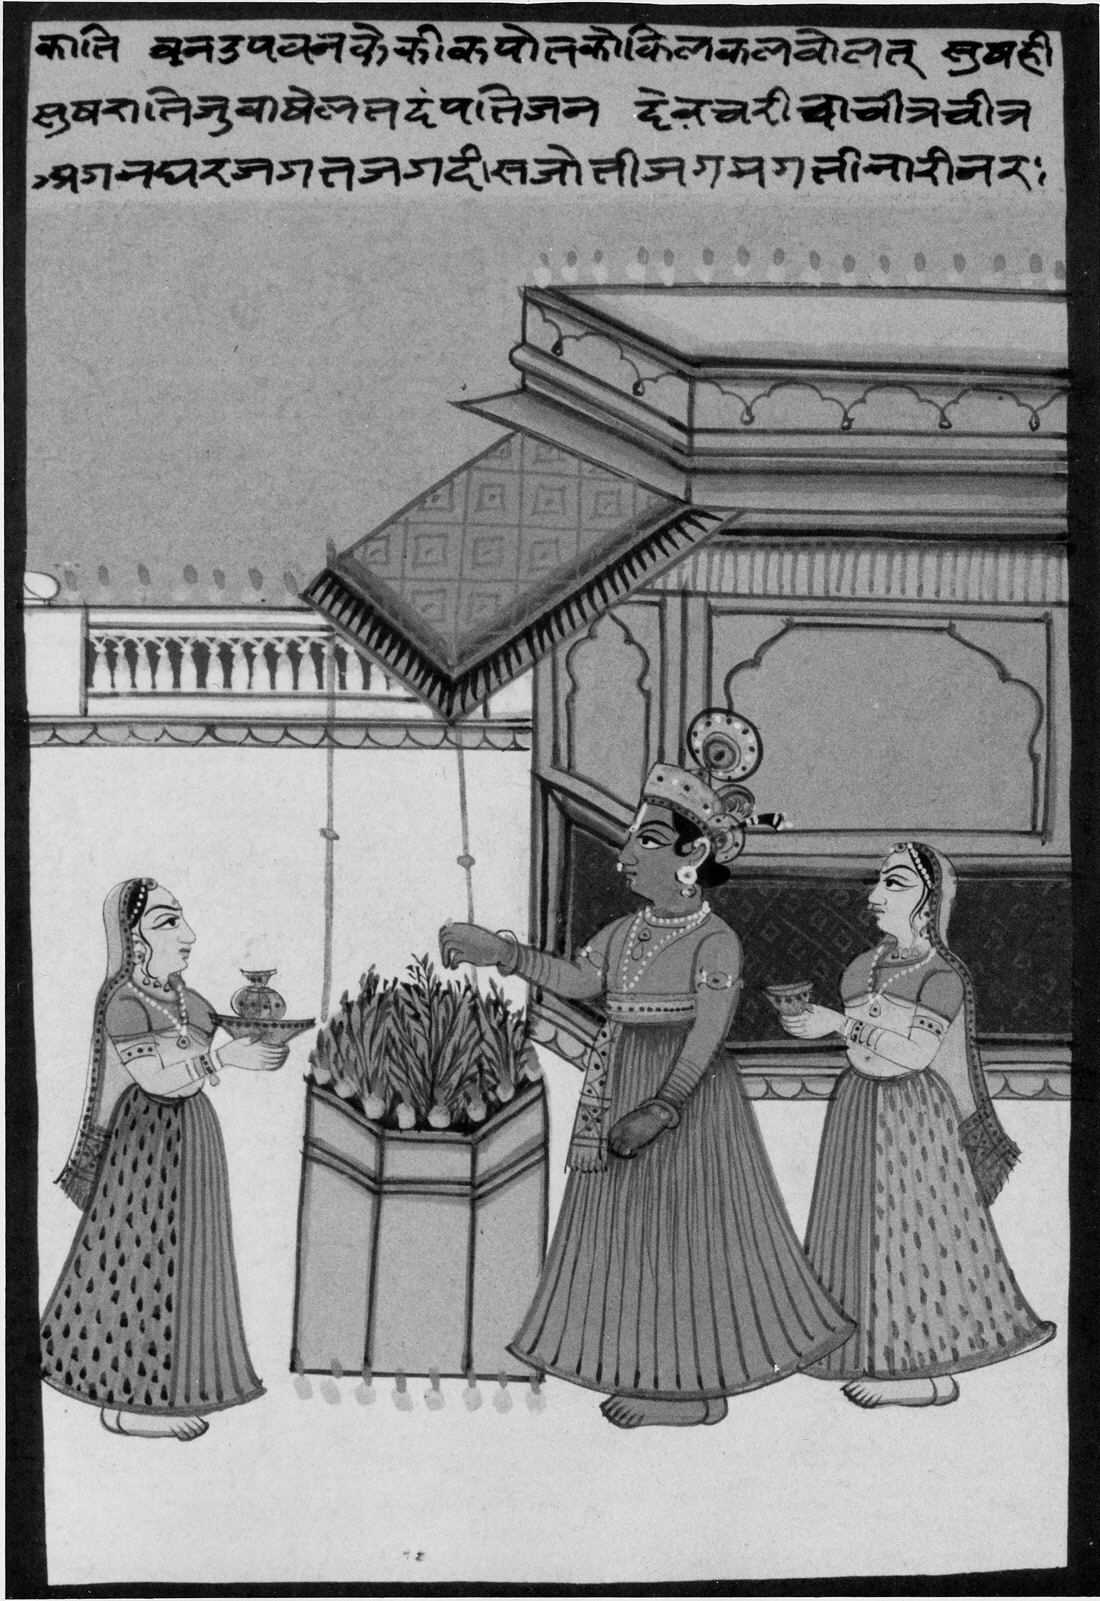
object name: leaf from a ragamala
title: Krishna with Two Attendants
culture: indian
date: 1867-1933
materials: gold, paper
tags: women,krishna